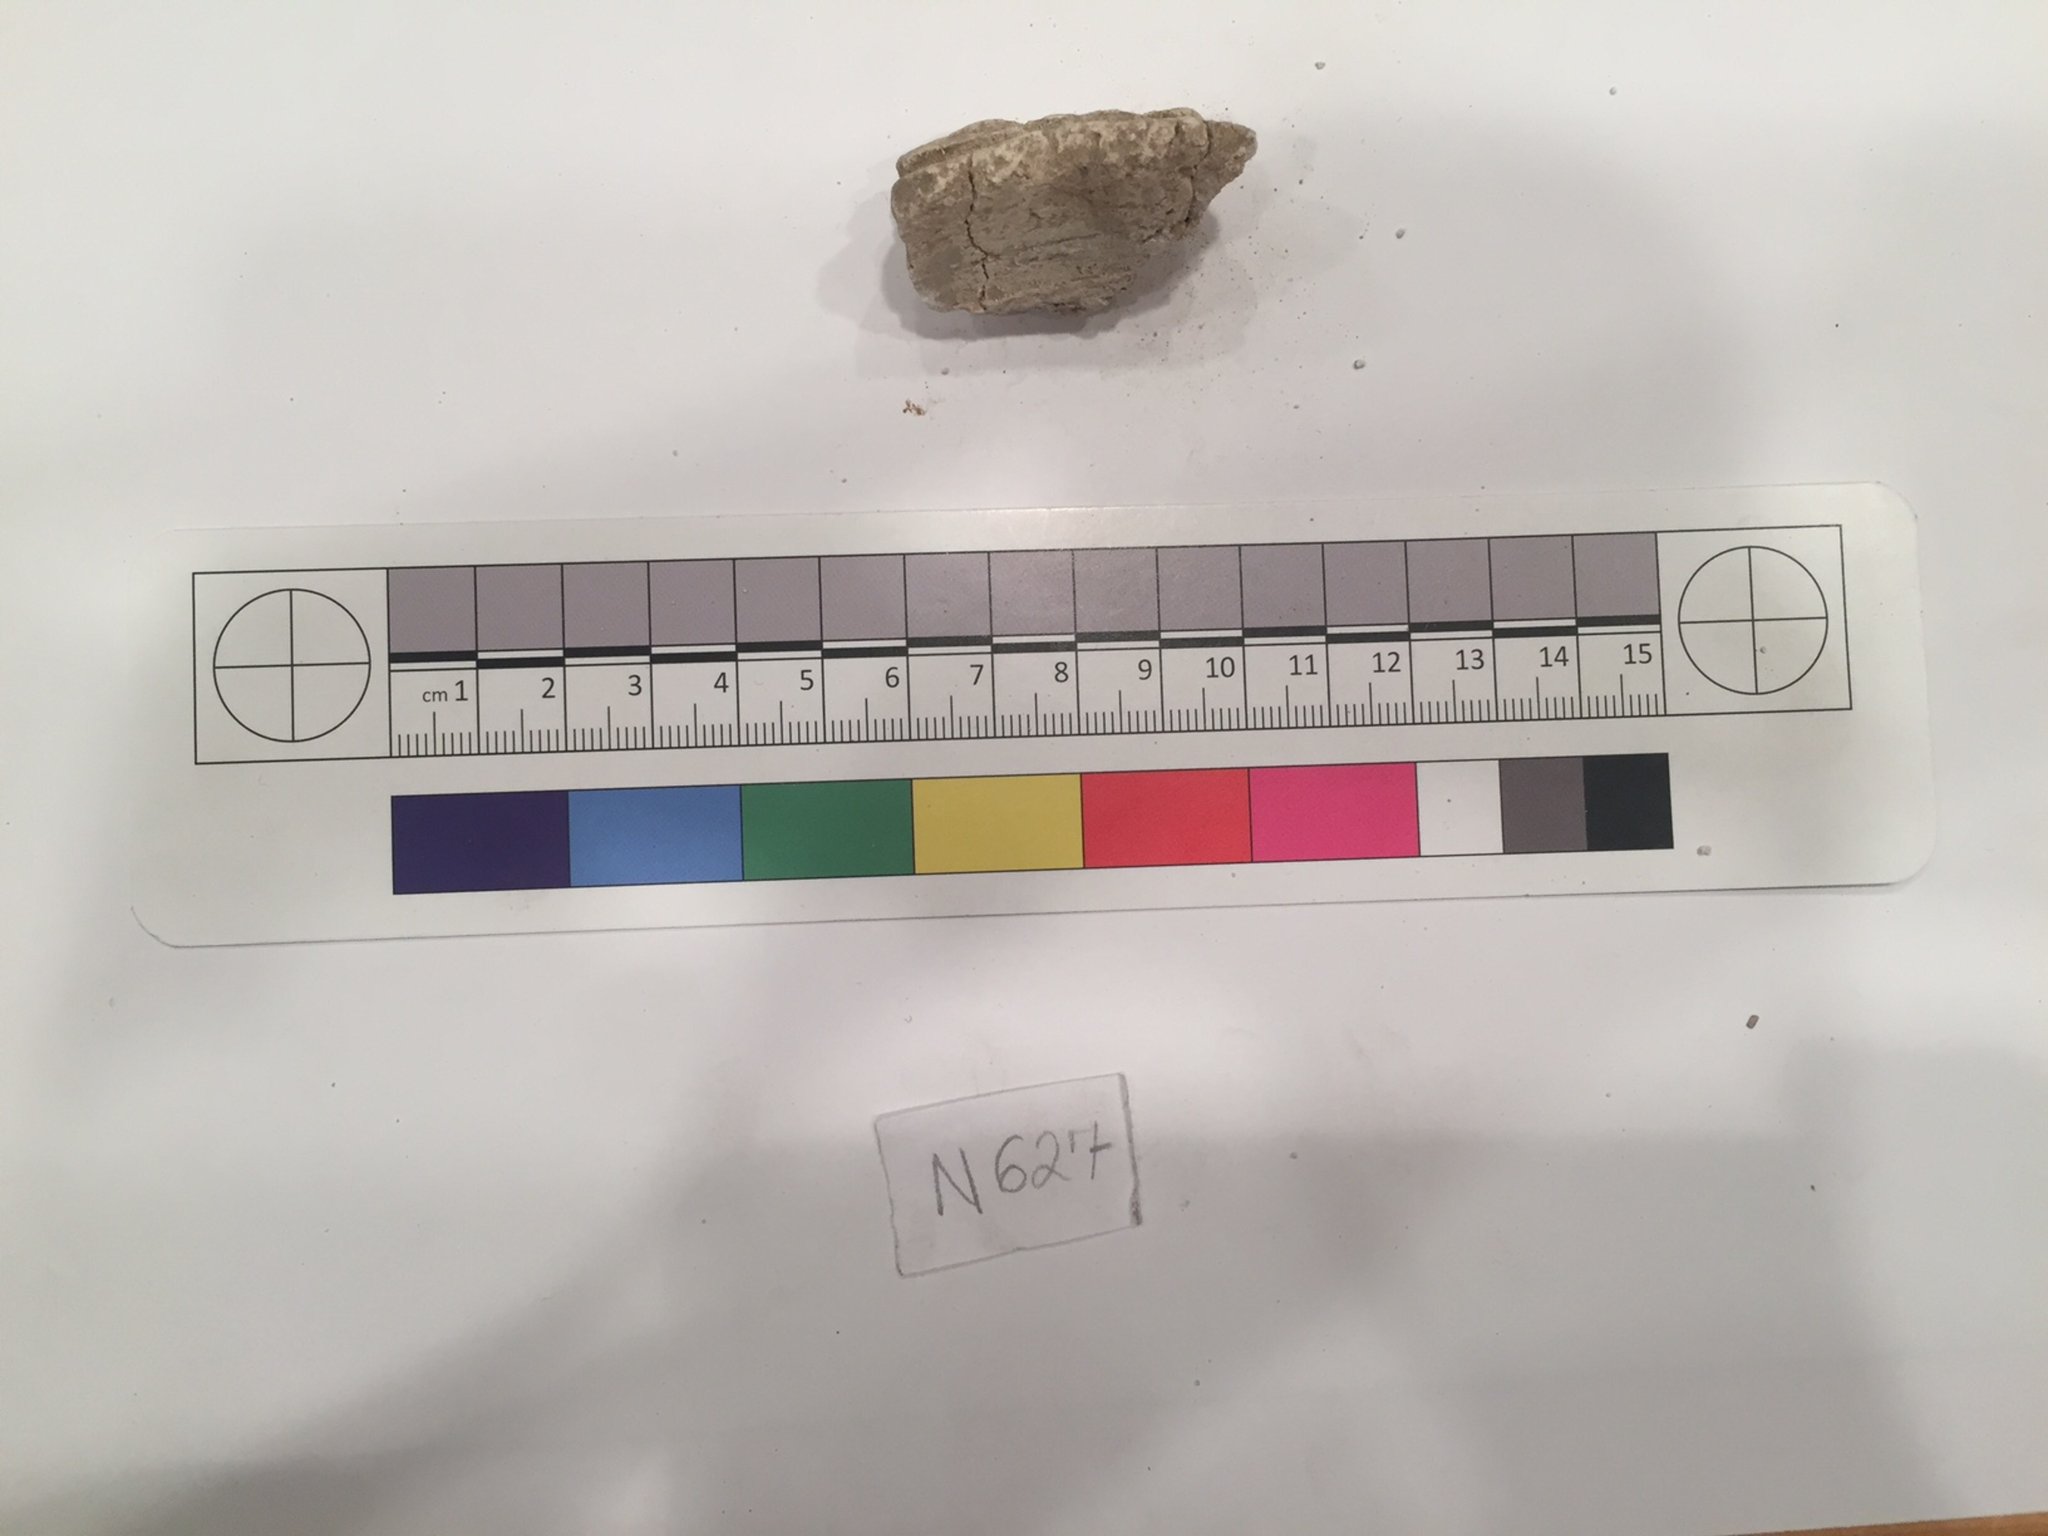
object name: fragment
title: Stucco Fragment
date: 701-1200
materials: plaster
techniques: carving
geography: iran